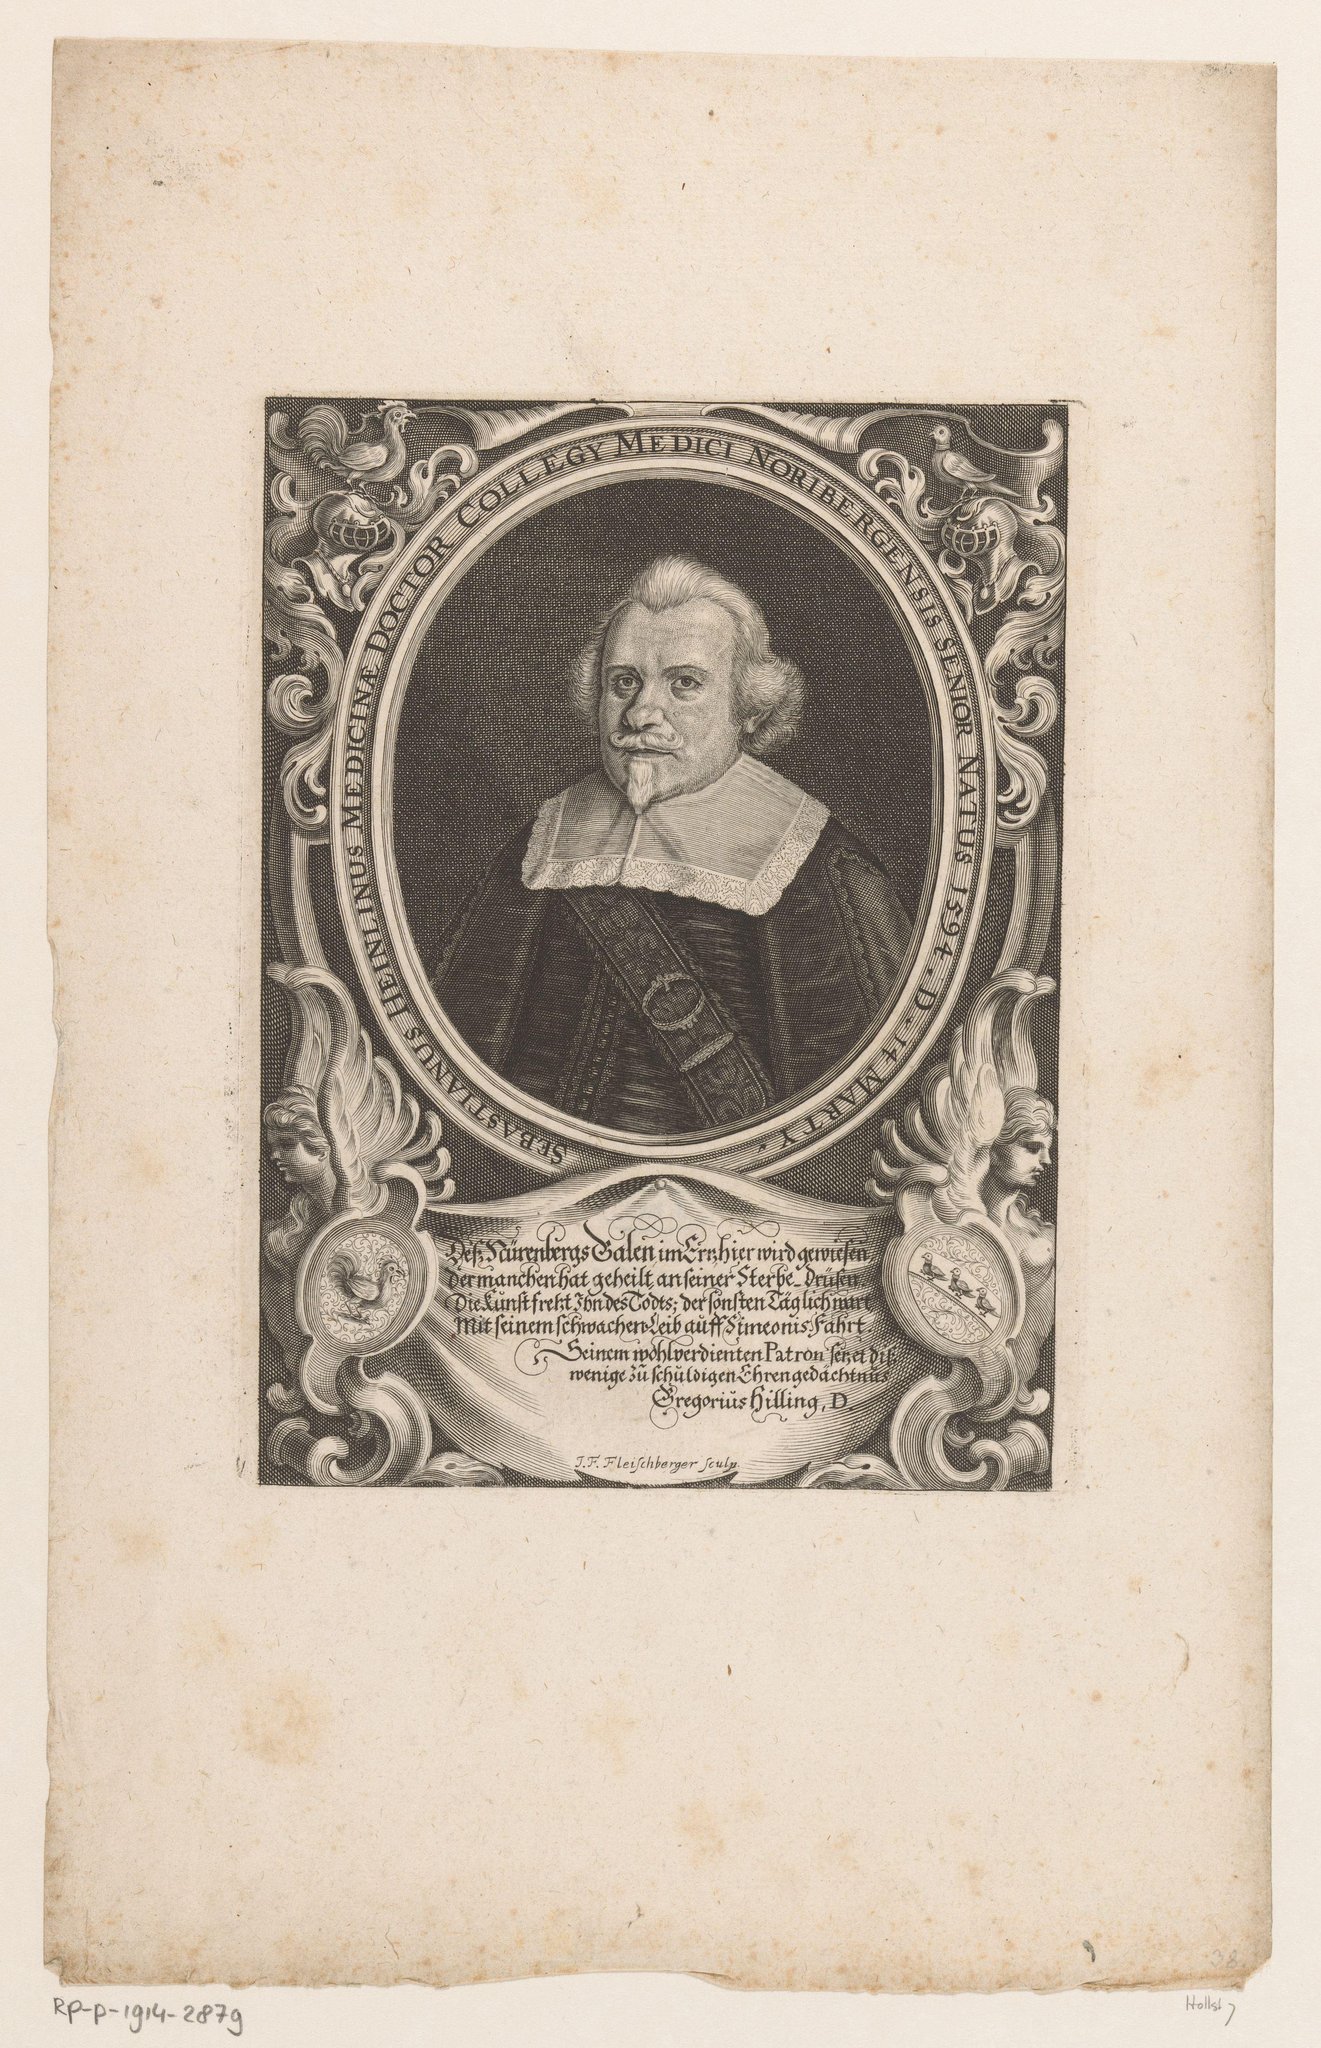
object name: print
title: Portret van Sebastian Hainlin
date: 1641-1663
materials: paper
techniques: engraving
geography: nuremberg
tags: historical persons, ornament ~ cartouche, armorial bearing, heraldry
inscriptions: collector's mark: Lugt 2228